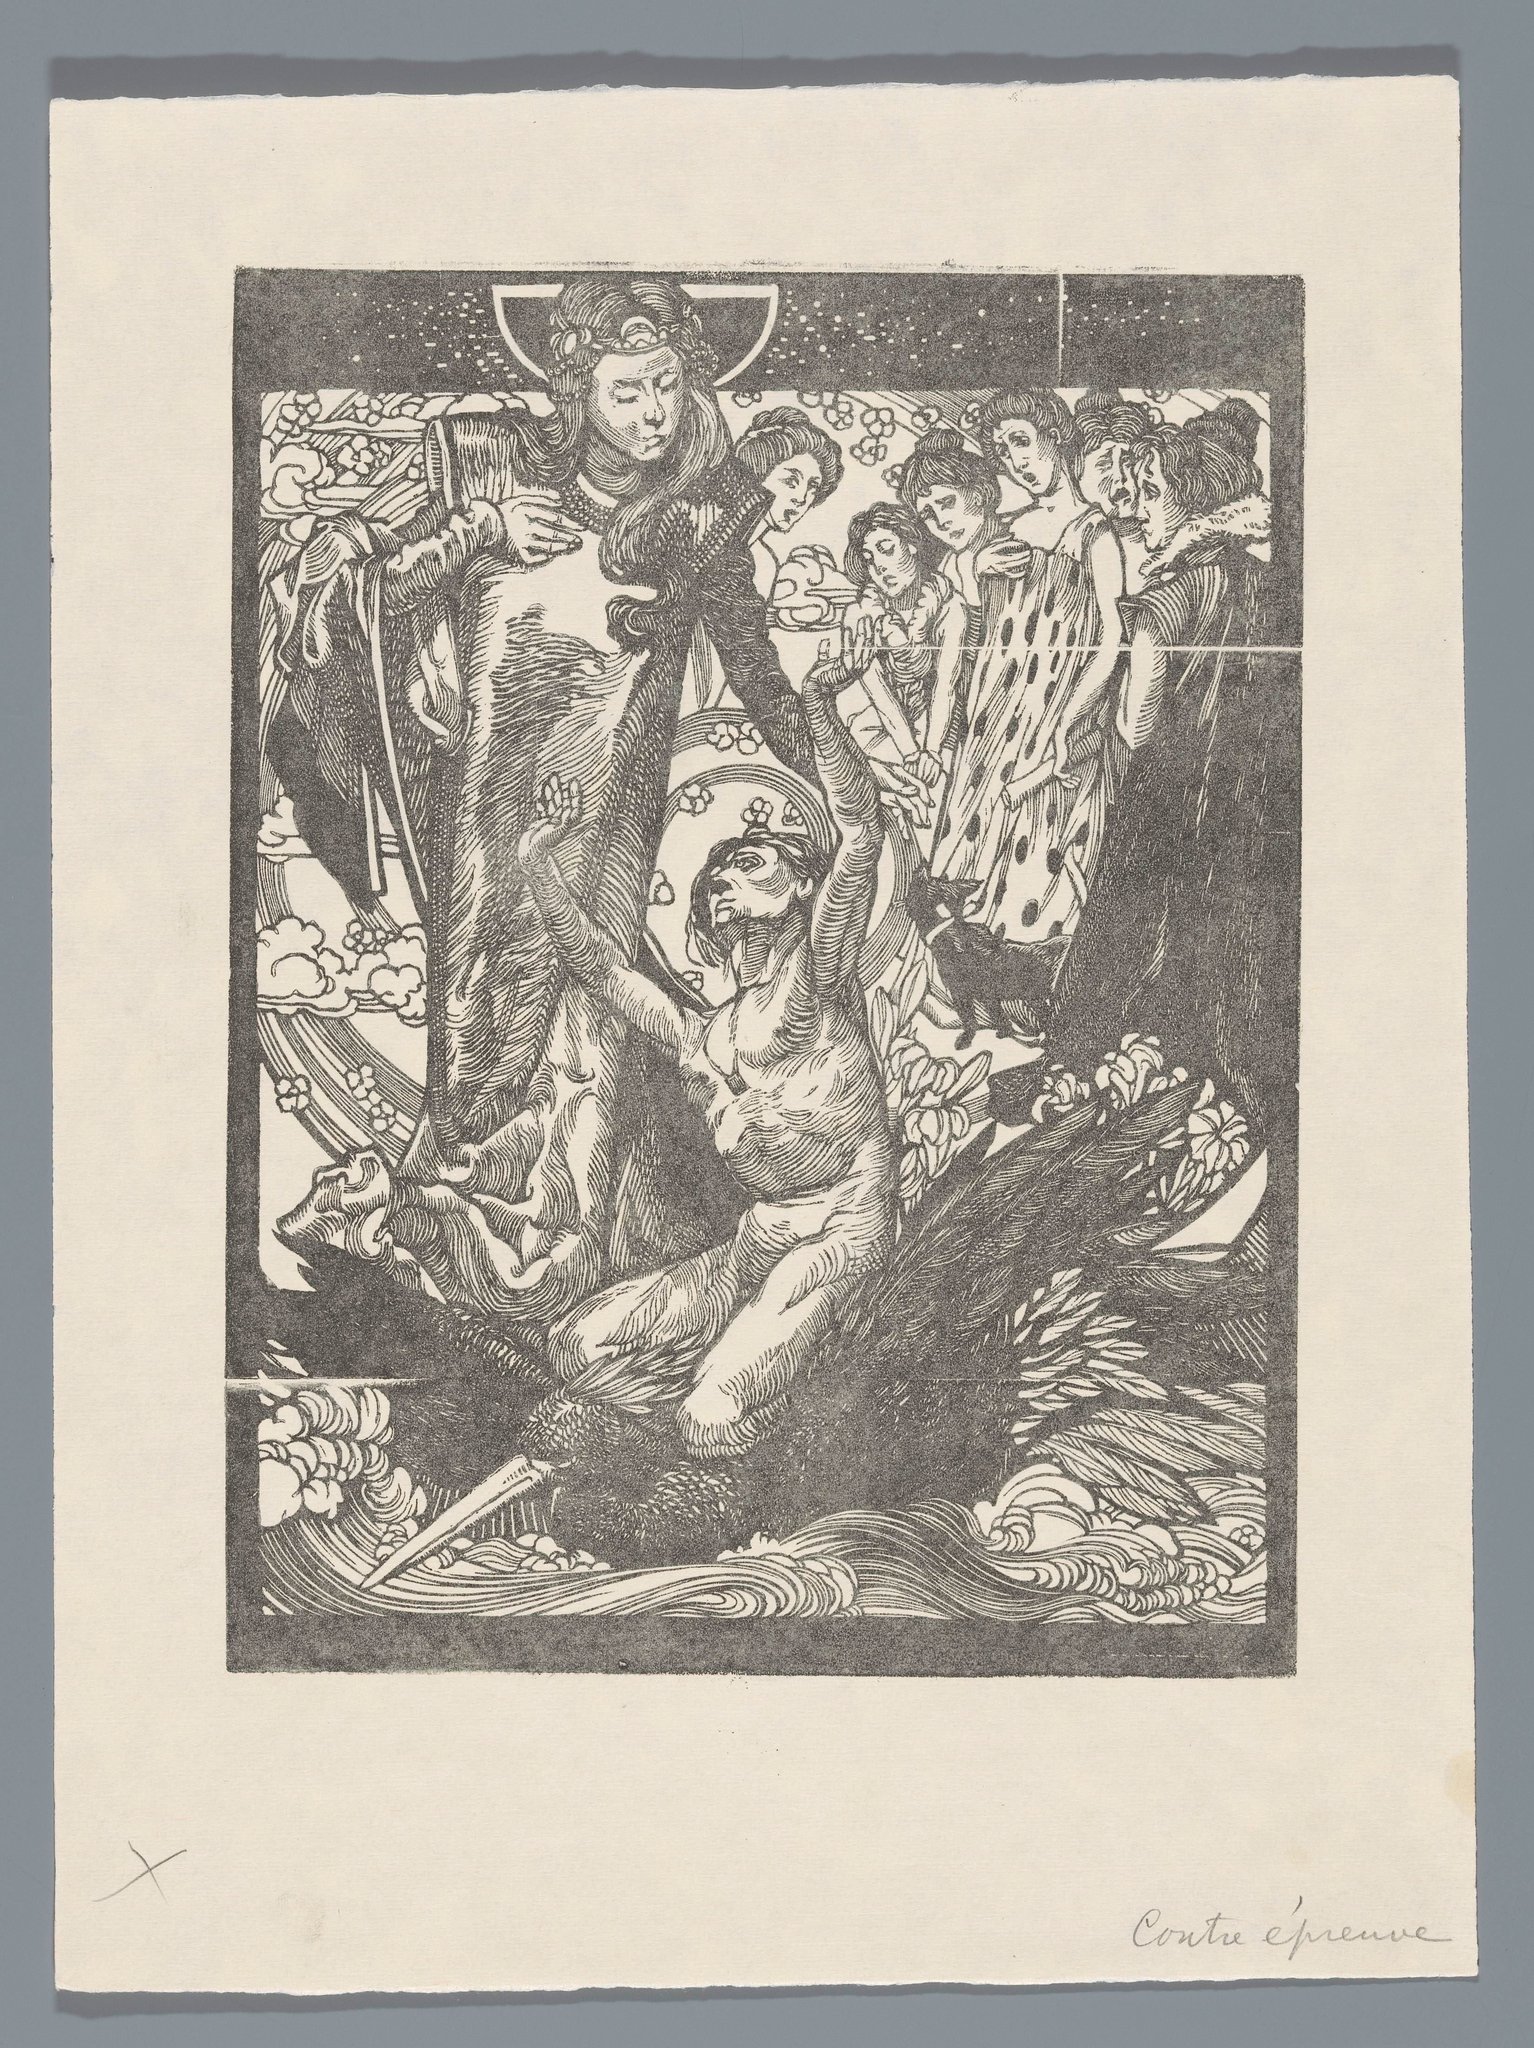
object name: print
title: Vrouwenfiguren met man op rug van vogel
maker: johannes josephus aarts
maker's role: draughtsman, print maker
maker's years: 1871-1934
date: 1881-1934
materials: paper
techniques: printmaking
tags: flying on or with the aid of animal(s), flowers, cat, birds, surrealia, surrealistic representations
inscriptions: annotation: ‘contre épreuve’, collector's mark: Lugt 2228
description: Een naakte man vliegt op de rug van een vogel. Hij heft zijn armen ten hemel. Hij wordt van boven bekeken door verschillende vrouwen gekleed in jurken. Er is een kat in hun midden. In de lucht zweven wolken en bloemen.